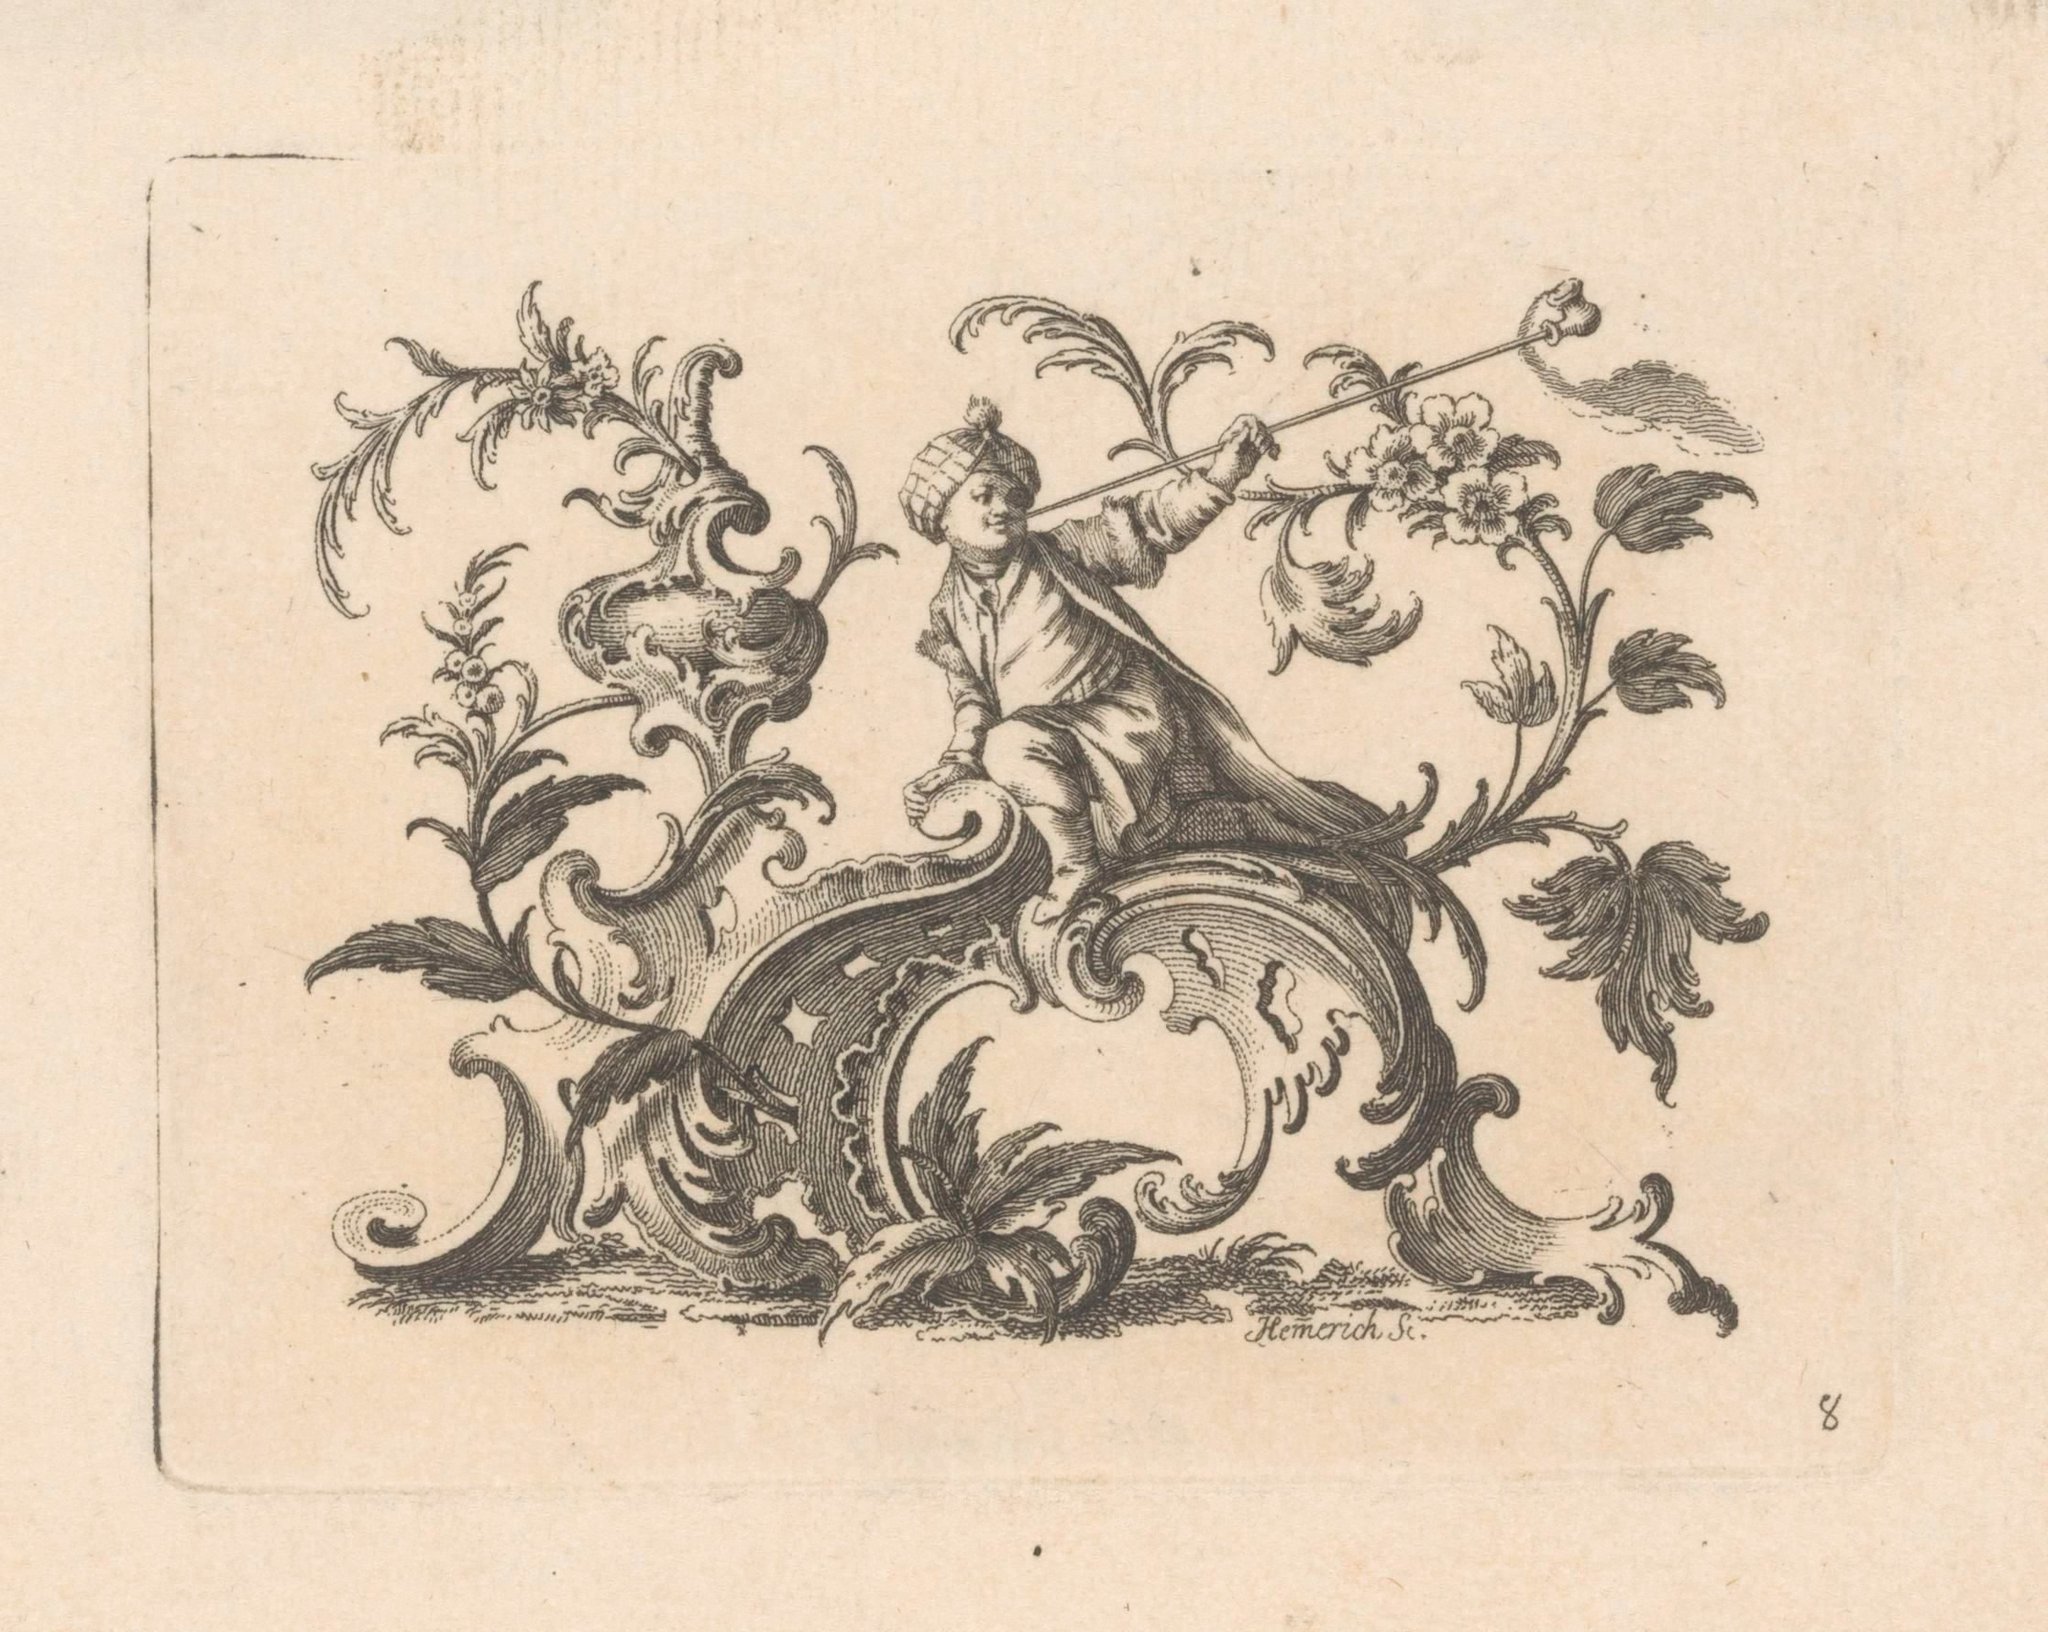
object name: ornament print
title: Man met tulband en pijp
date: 1731-1780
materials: paper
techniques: engraving, etching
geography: london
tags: pipe ~ tobacco (+ taking (particular) foodstuffs: eating, drinking, smoking, chewing, etc.)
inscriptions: collector's mark: Lugt 2760, collector's mark: Lugt 2228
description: Een man met een tulband en een lange pijp zit op een rocaille ornament.